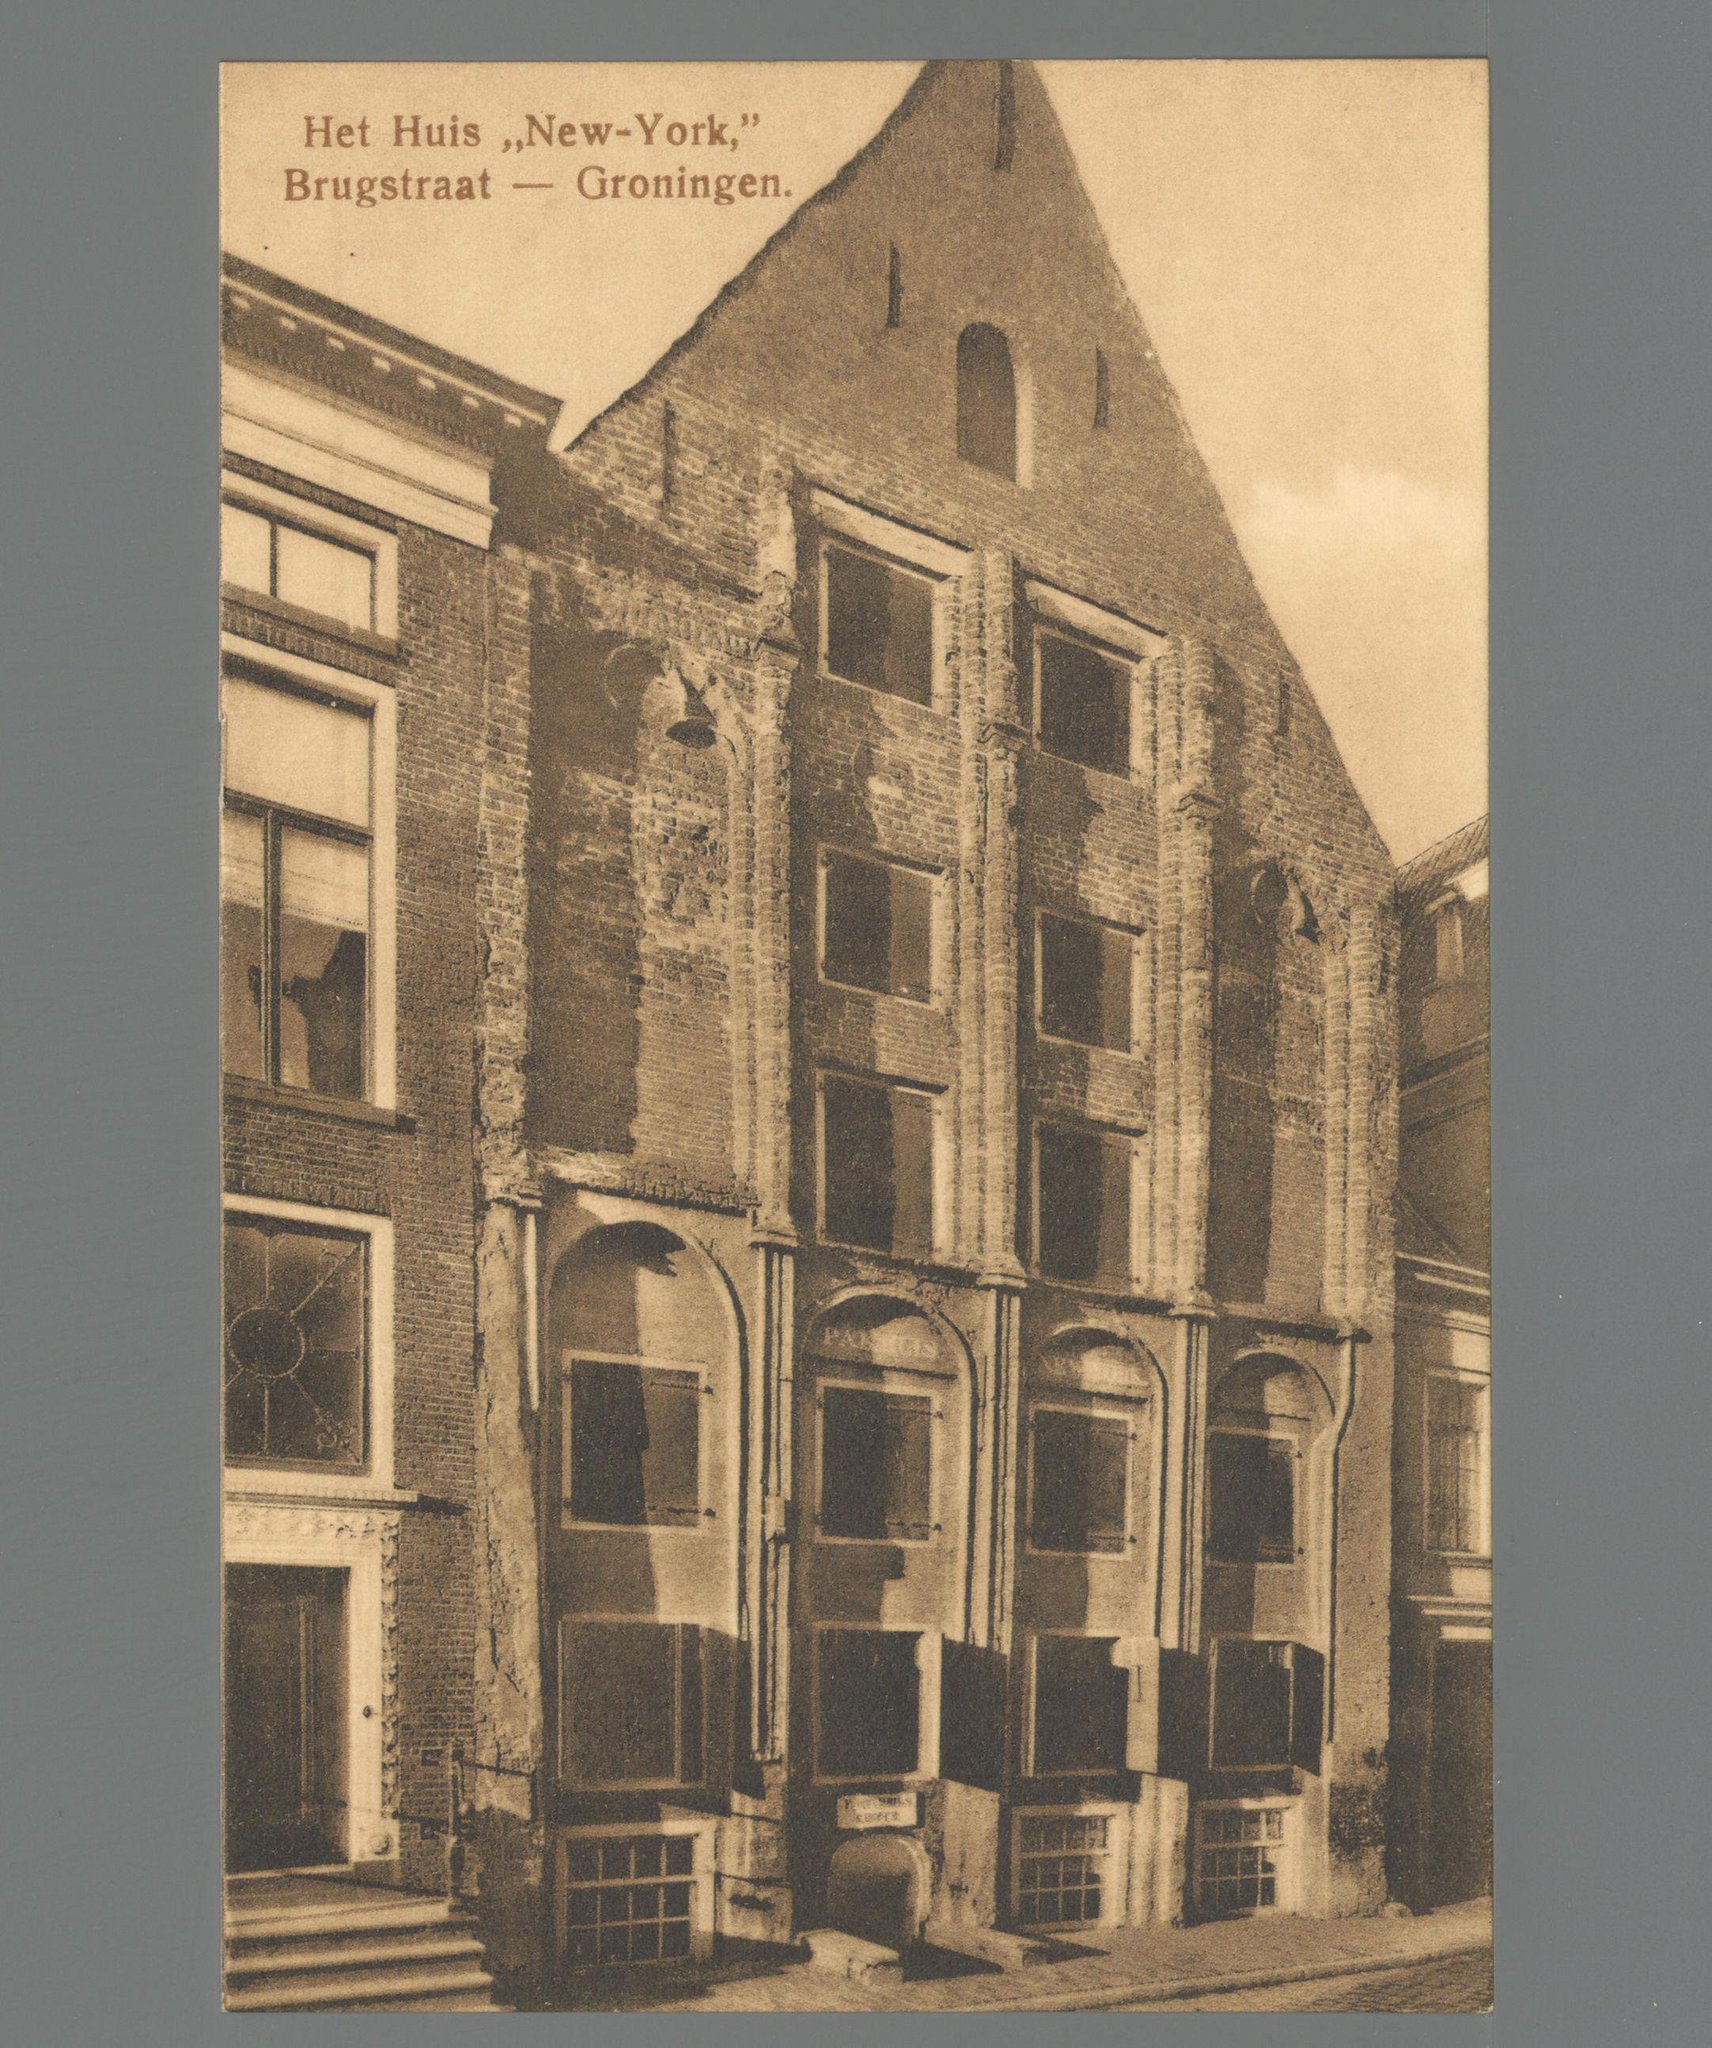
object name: photomechanical print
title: Het huis "New-York," Brugstraat - Groningen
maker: Anonymous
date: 1905-1930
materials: cardboard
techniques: photograph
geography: groningen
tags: façade (of house or building)